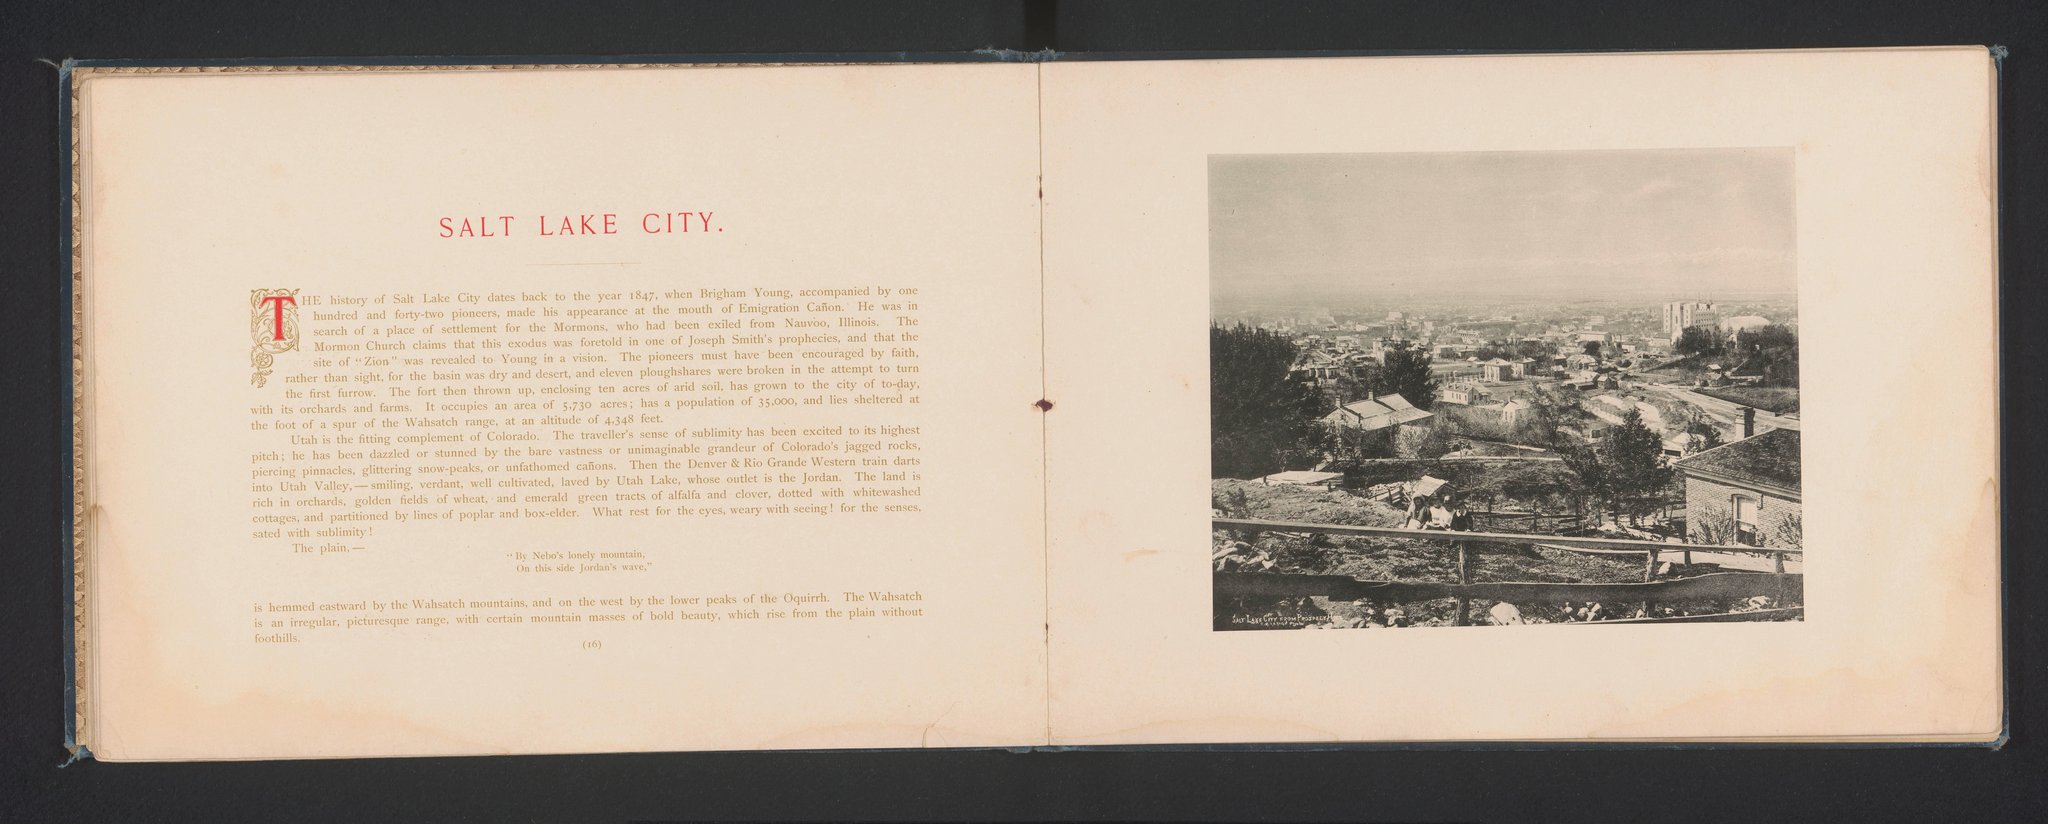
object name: page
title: Salt Lake City from Prospect Hill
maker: charles roscoe savage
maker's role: fotograaf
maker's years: 1832-1909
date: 1883-1888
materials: paper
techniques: photograph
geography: boston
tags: city-view, and landscape with man-made constructions